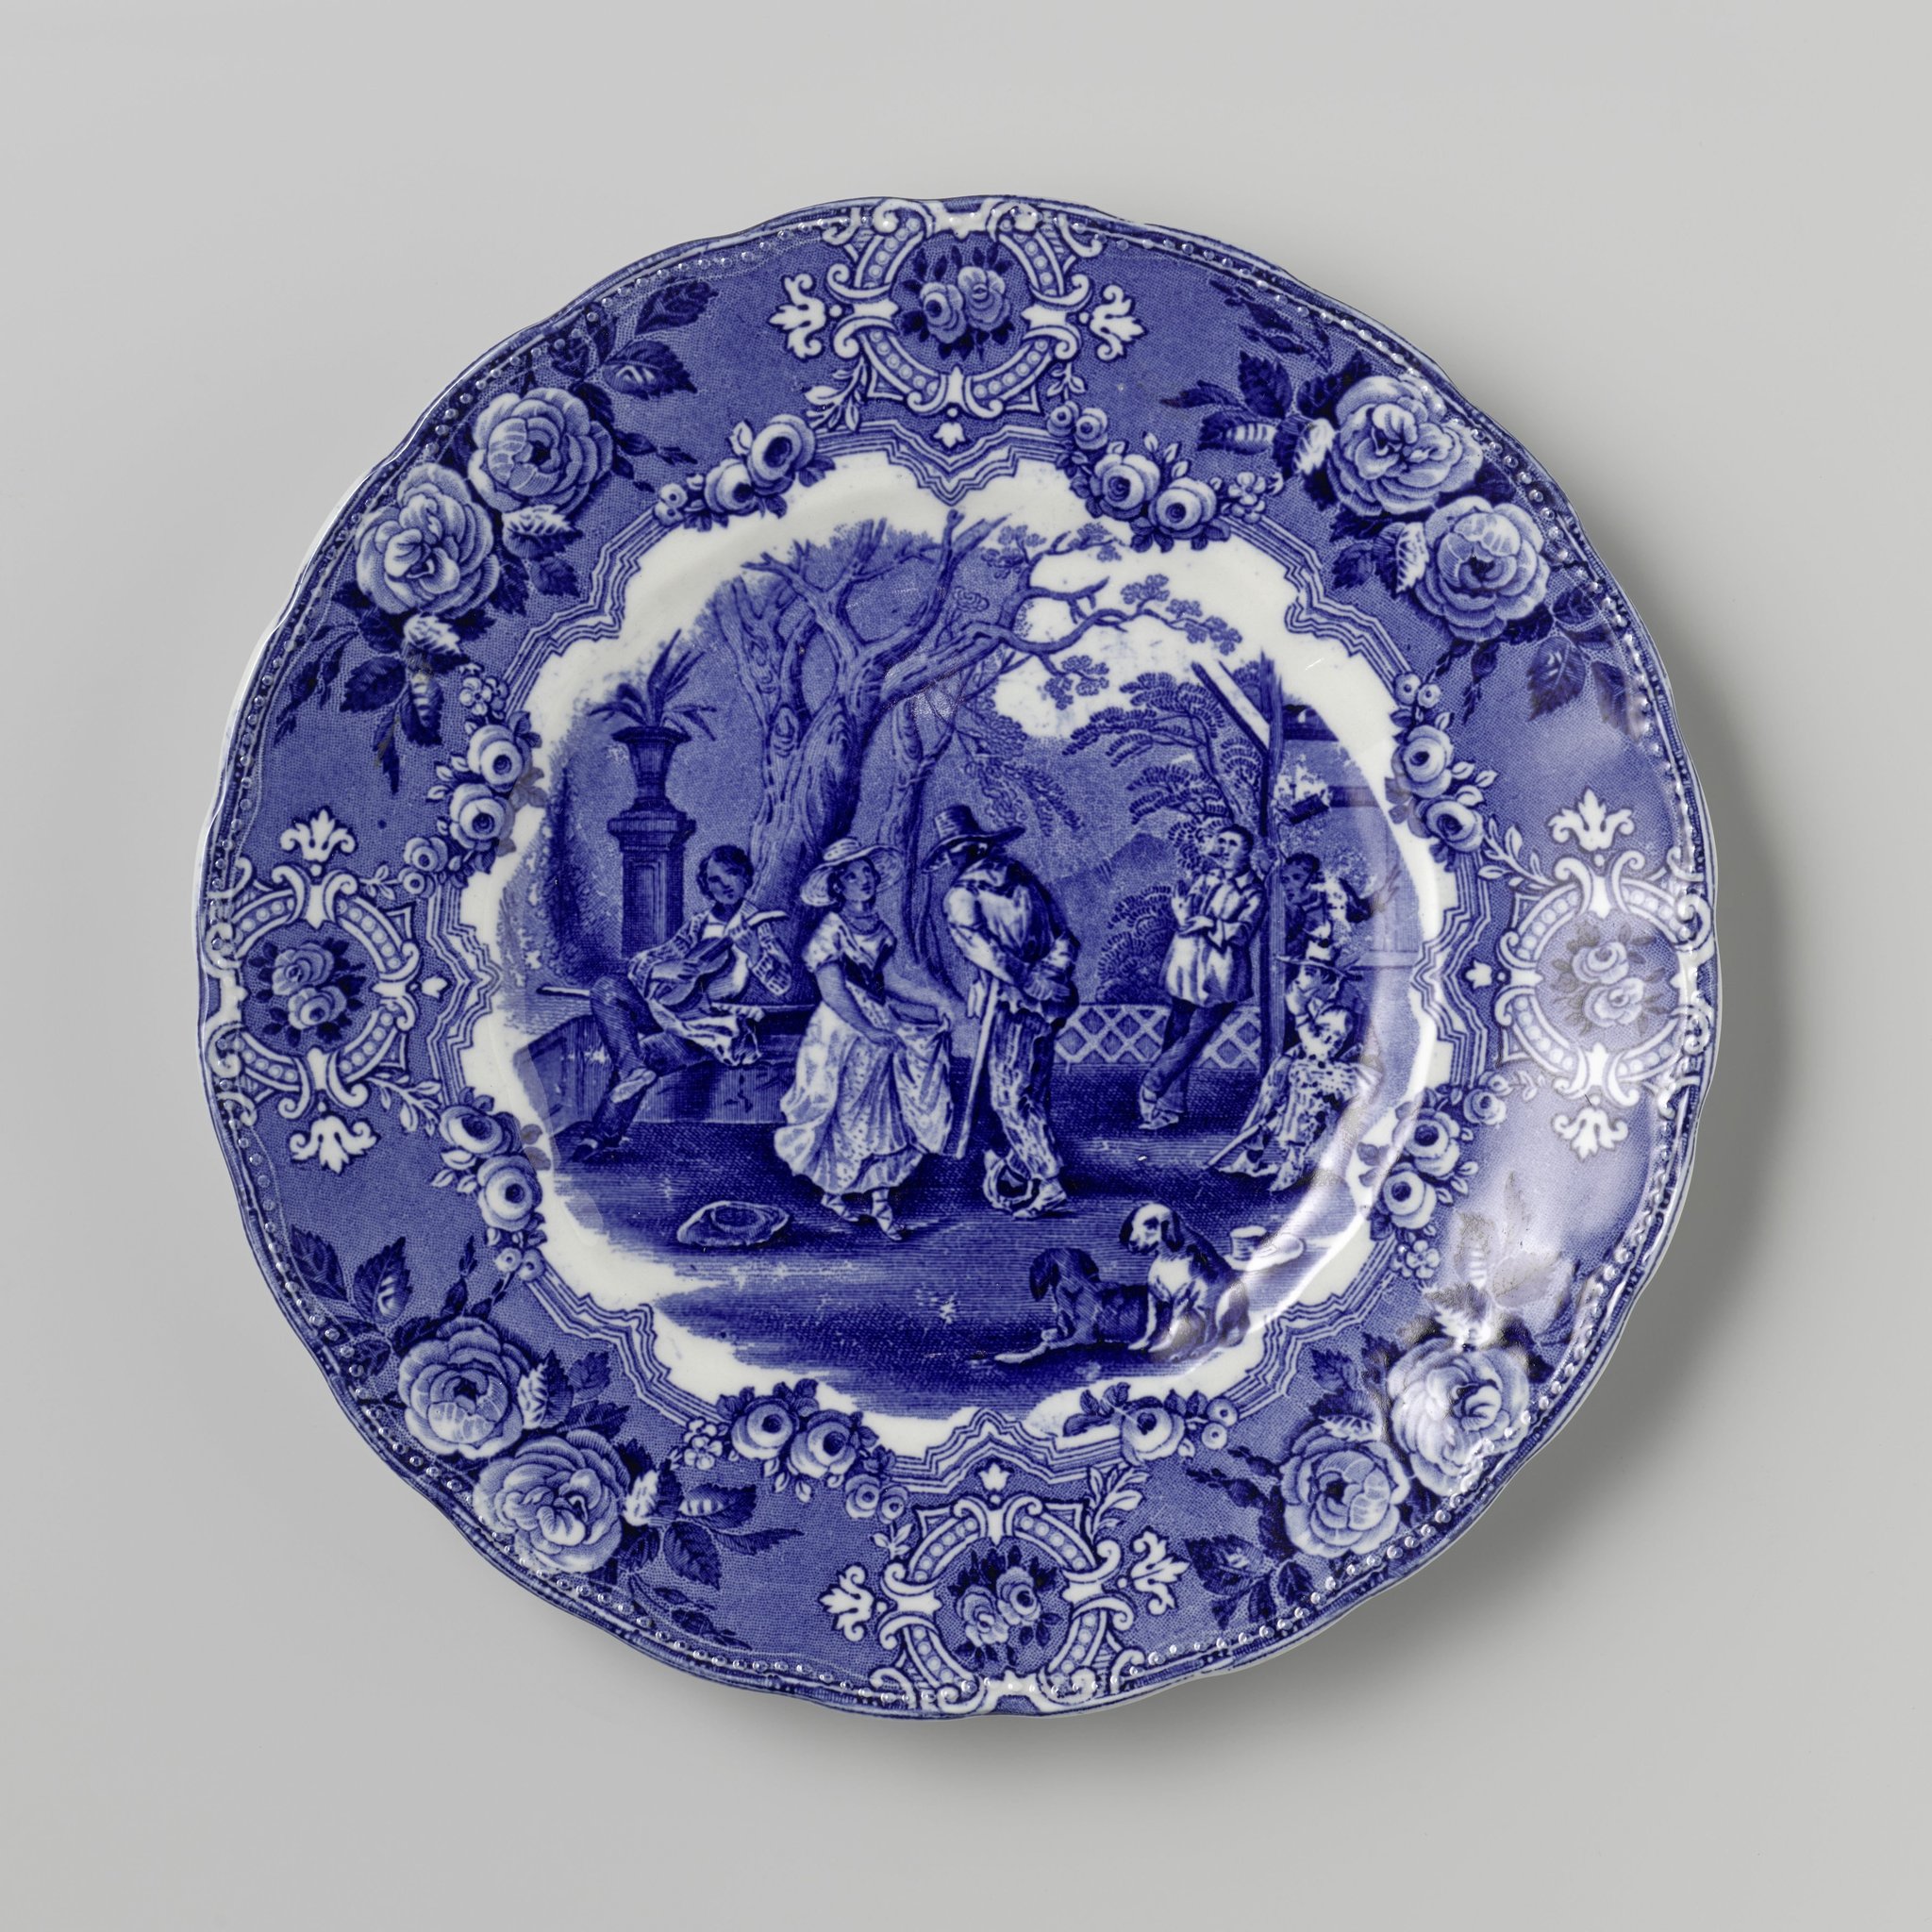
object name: plate dish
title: Bord met op het plat een musicerend en dansend gezelschap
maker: Anonymous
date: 1400-1950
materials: earthenware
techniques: transfer decoration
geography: england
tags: small group of musicians, chamber orchestra, jazz band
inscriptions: check stamp: ‘5 // 24 en een wassende maan’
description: Bord van aardewerk met vloeiblauw transferdecor. Op het plat een musicerend en dansend gezelschap in een tuin.